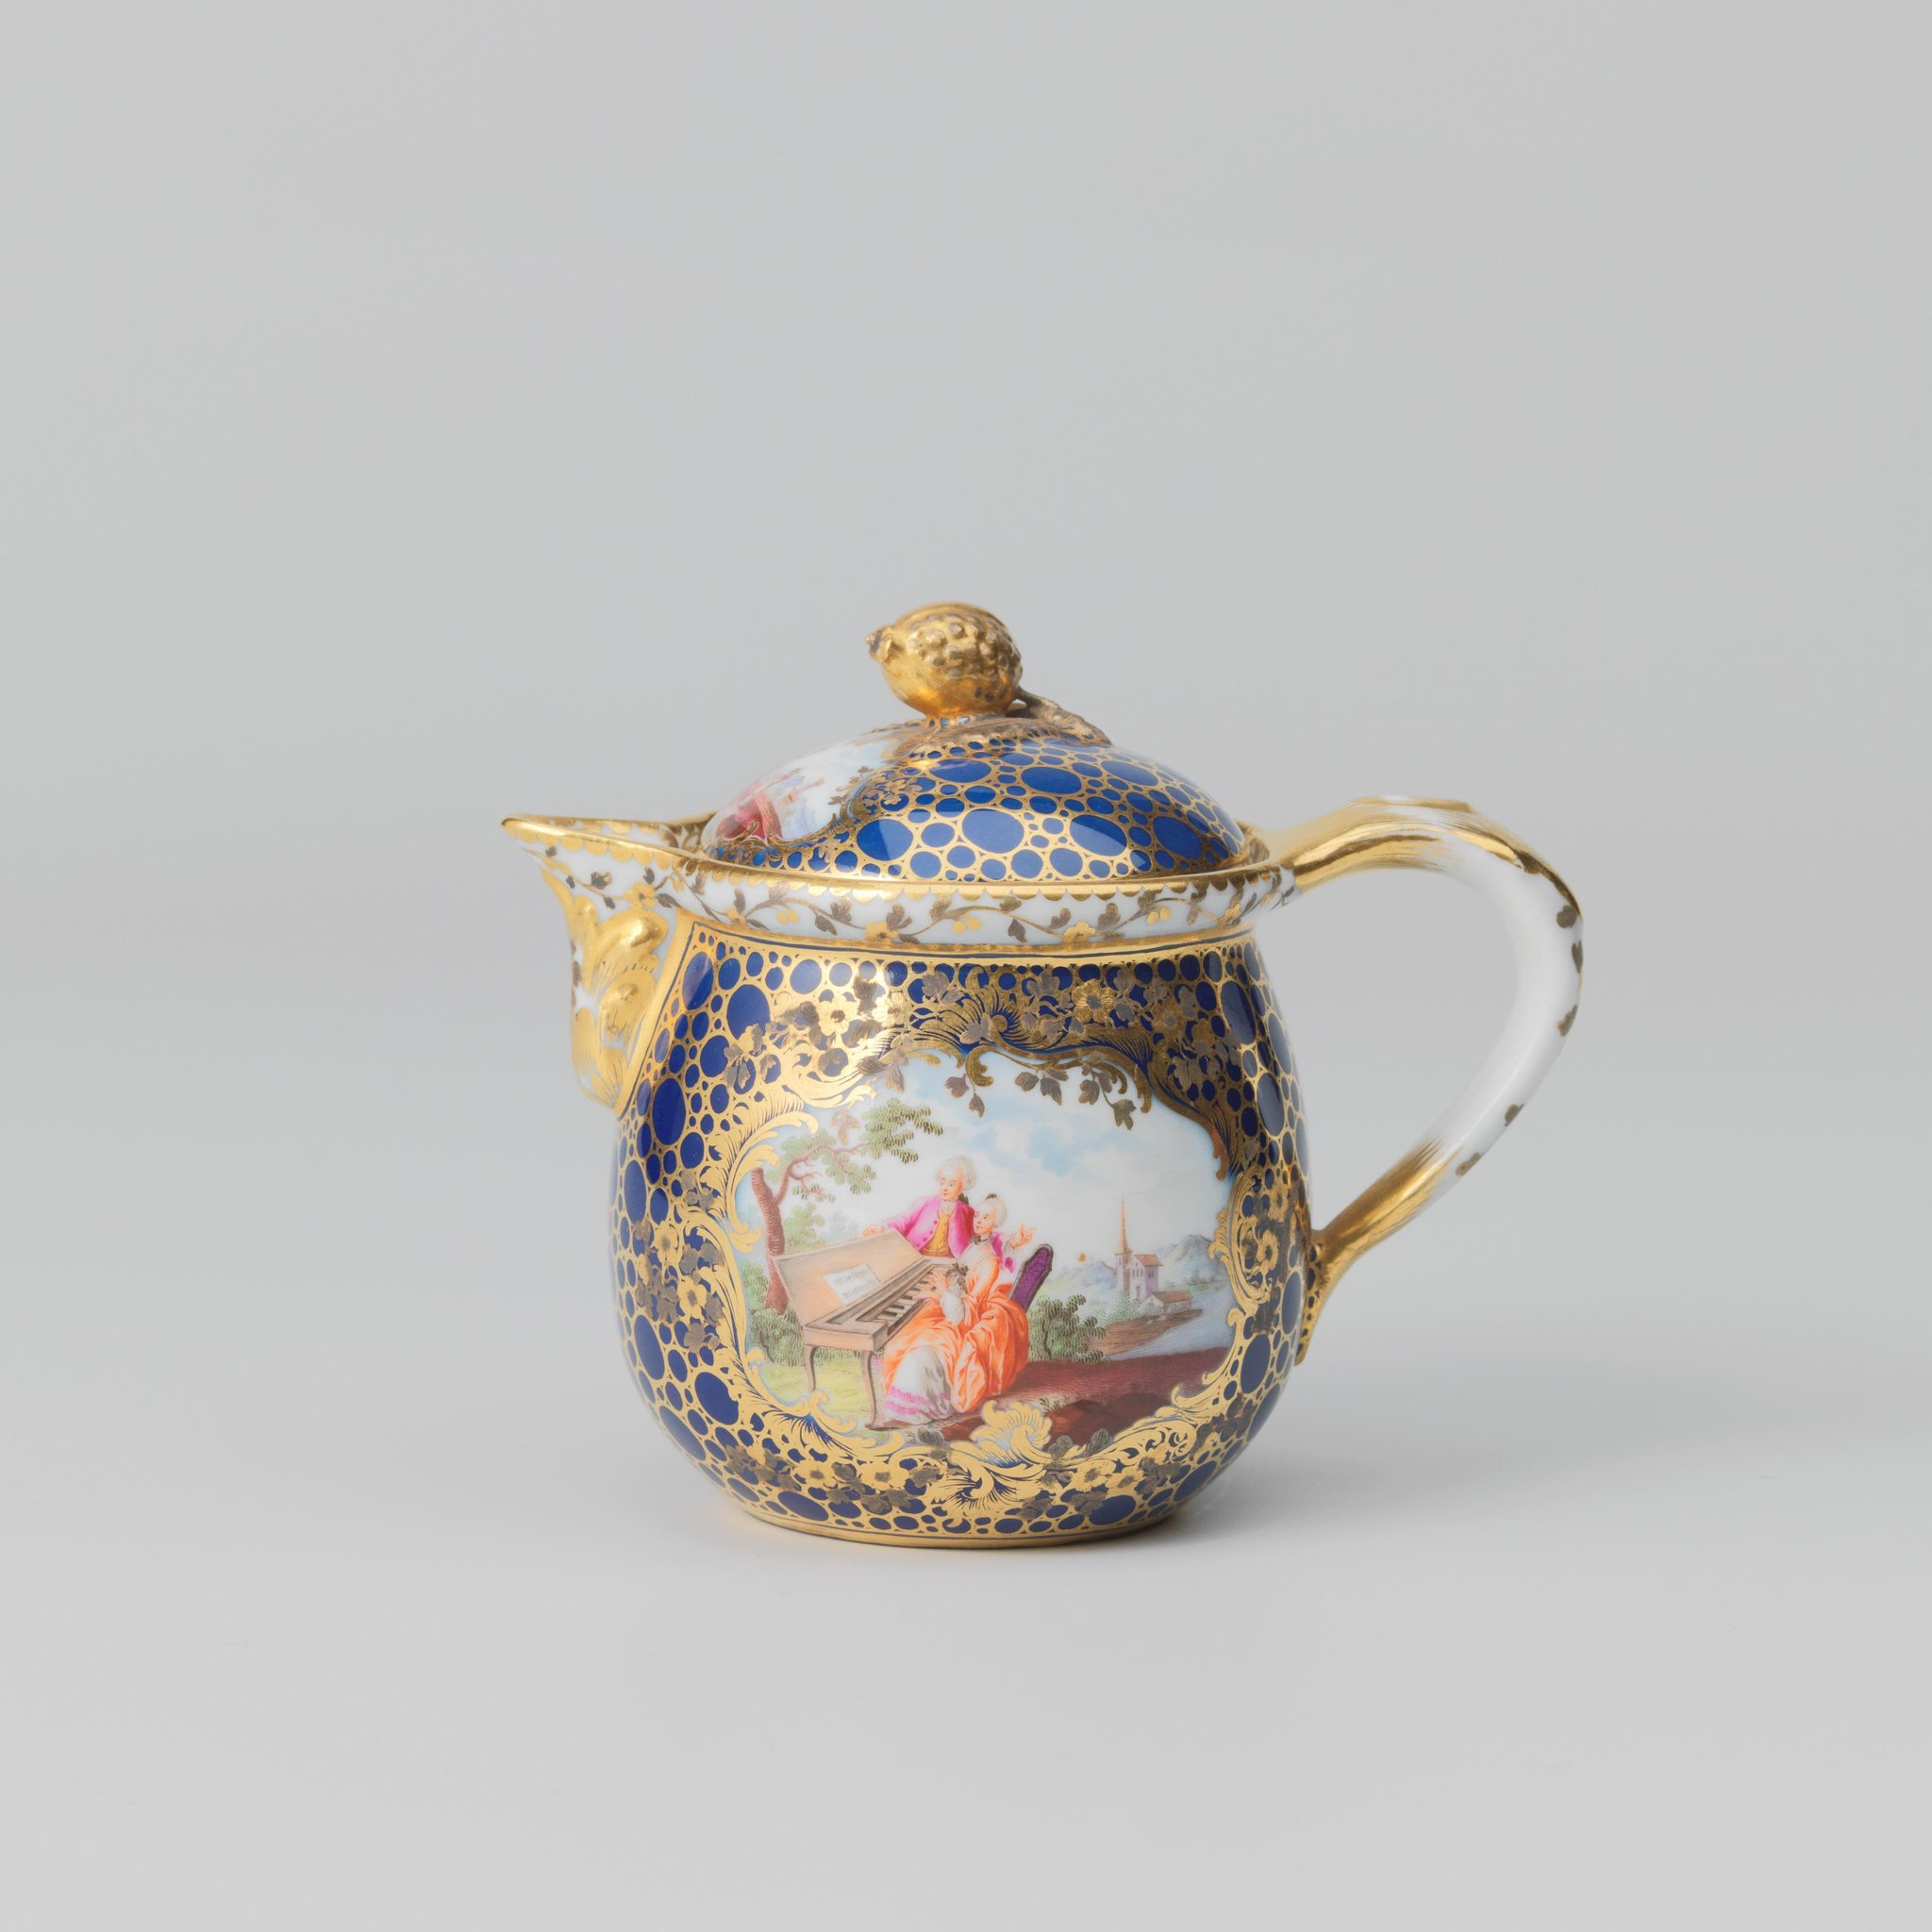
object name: milk jug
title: Cover with couple in a landscape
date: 1765-1770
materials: glaze, gold, paint, porcelain, silver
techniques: firing, gilding, turning, vitrification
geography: vienna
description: Deksel van porselein, beschilderd op het glauur in emailkleuren, zilver[?] en goud. De deksel is bedekt met blauw waarover in goud een patroon van cirkels is aangebracht. Versierd met een voorstelling van een dame die een hond aan het trainen is; dekselknop in de vorm van een granaatappel. Aan de binnenzijde een bloemtak.